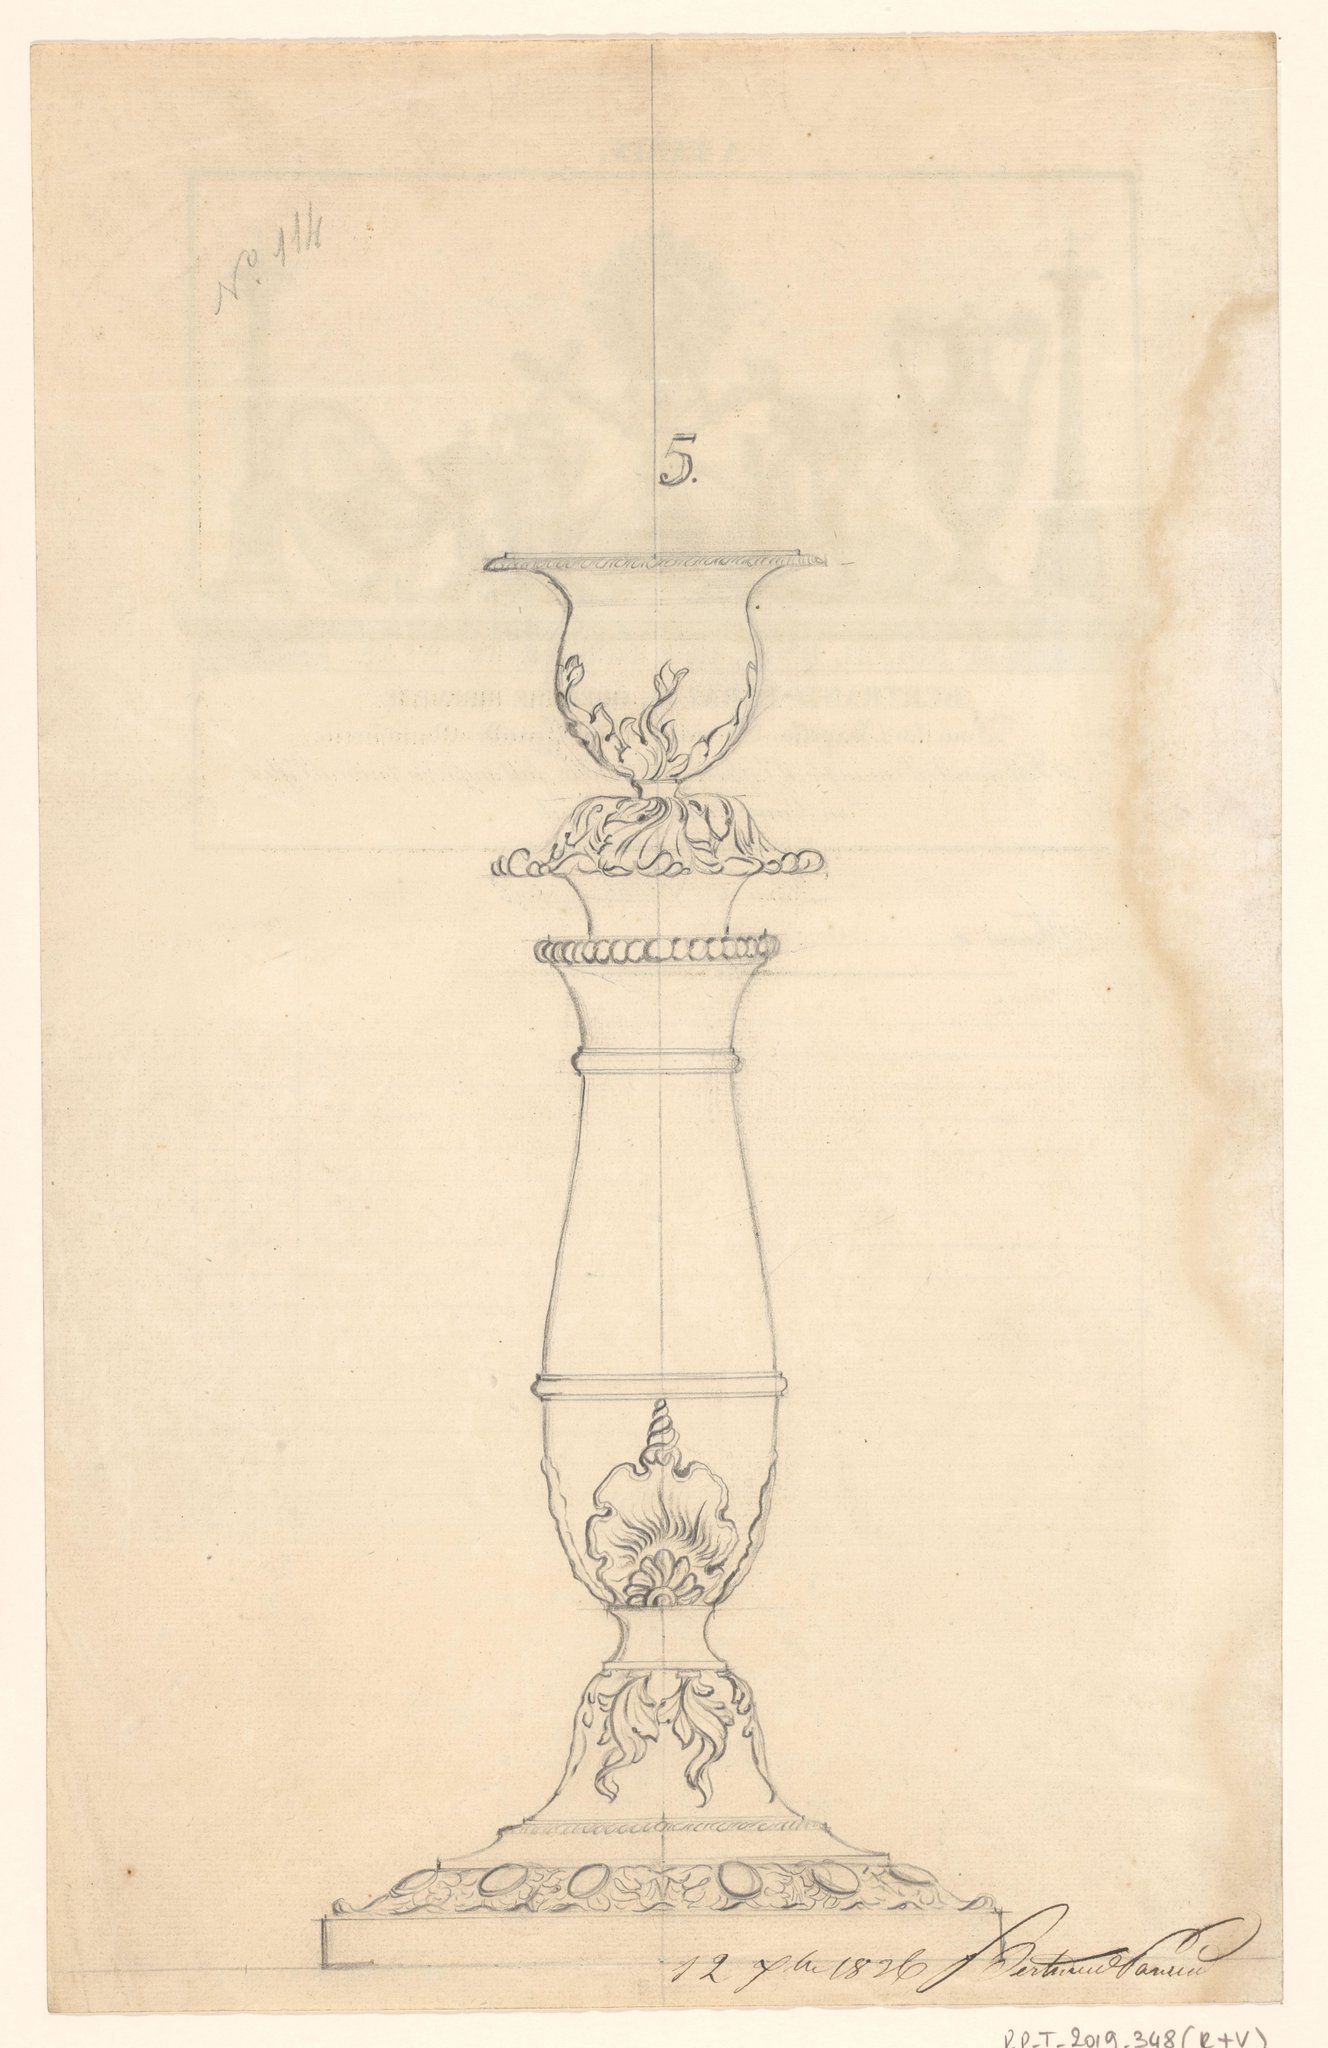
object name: design drawing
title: Ontwerp voor een kandelaar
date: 1826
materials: graphite, paper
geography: paris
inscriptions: number: ‘5’, signature and date: ‘12 Xbre 1826 F Bertrand Paraud’, number: ‘No. 114’, watermark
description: Het jaartal 1826 op de tekening is wellicht een vergissing voor 1836; dit wordt gesuggereerd door de in potlood aangebrachte datering op de verso en door vergelijking met RP-T-2019-349.